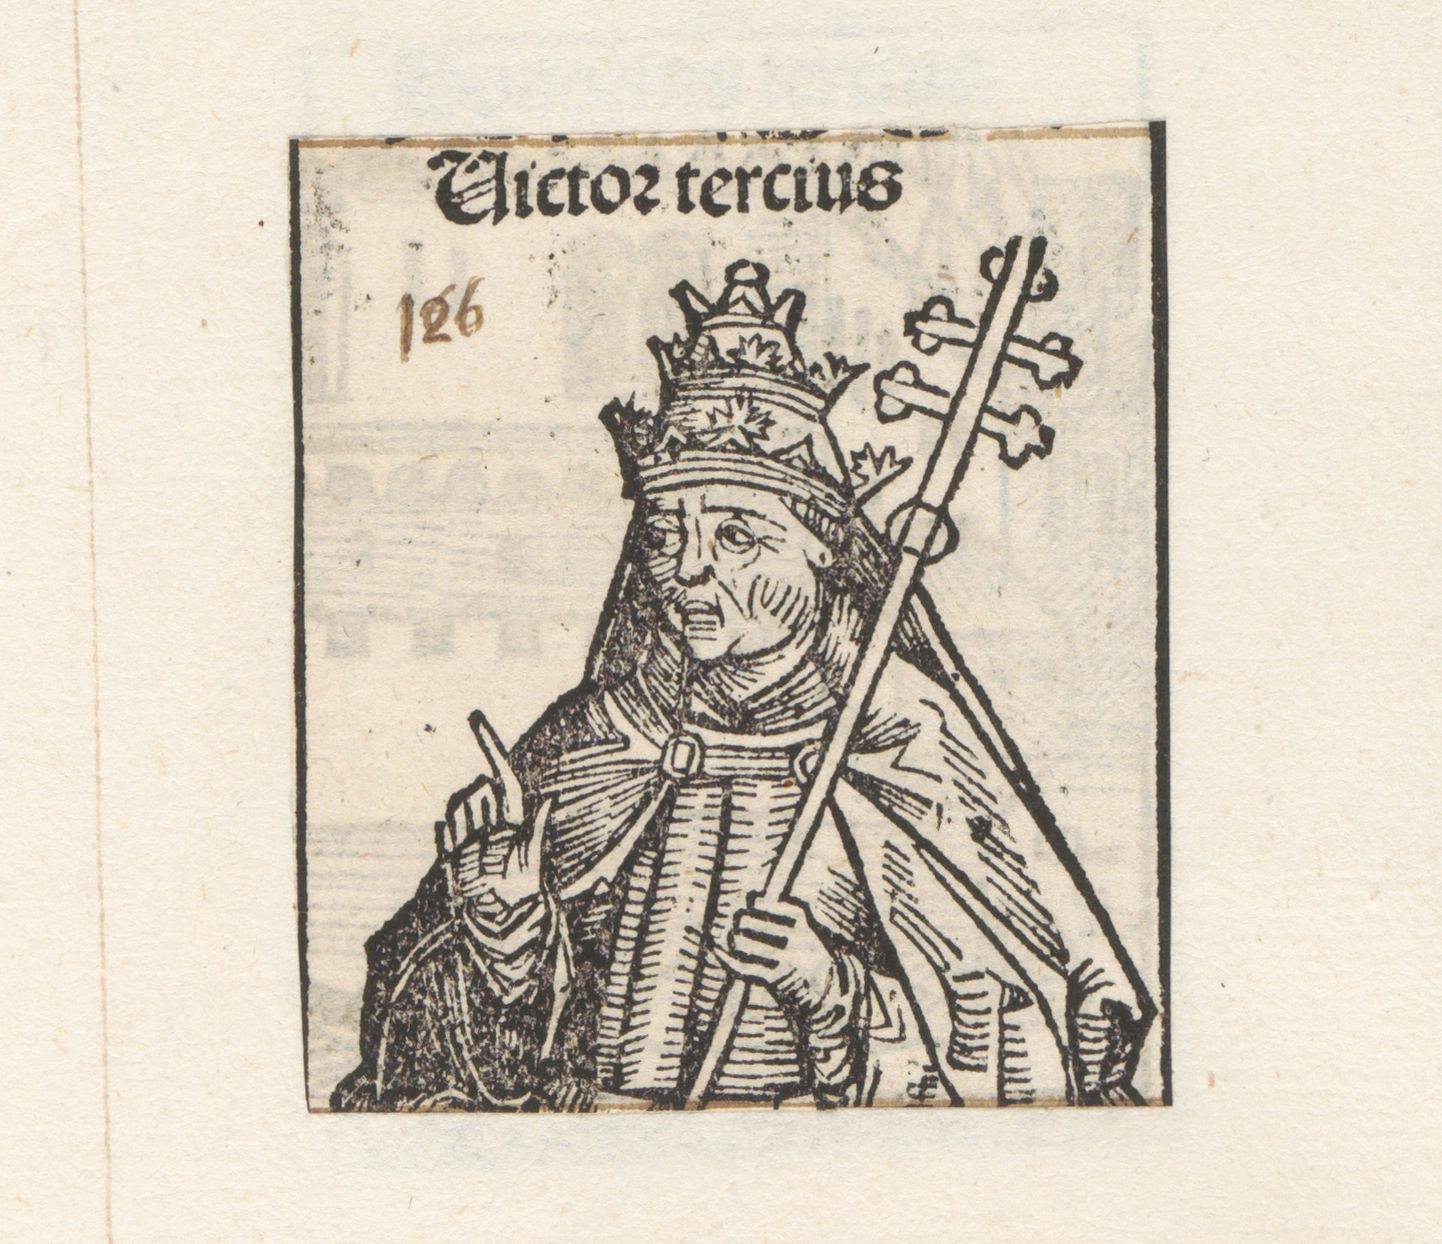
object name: print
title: Victor tercius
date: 1493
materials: paper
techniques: letterpress printing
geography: nuremberg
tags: pope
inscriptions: inscription: ‘126’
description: Een paus. Hij draagt een tiara en heeft een staf met een dubbel kruis in zijn handen. De voorstelling is onderdeel van de opeenvolging pausen in de Liber Chronicarum. De tekst identificeert de man als Victor III. De prent maakt deel uit van een album.